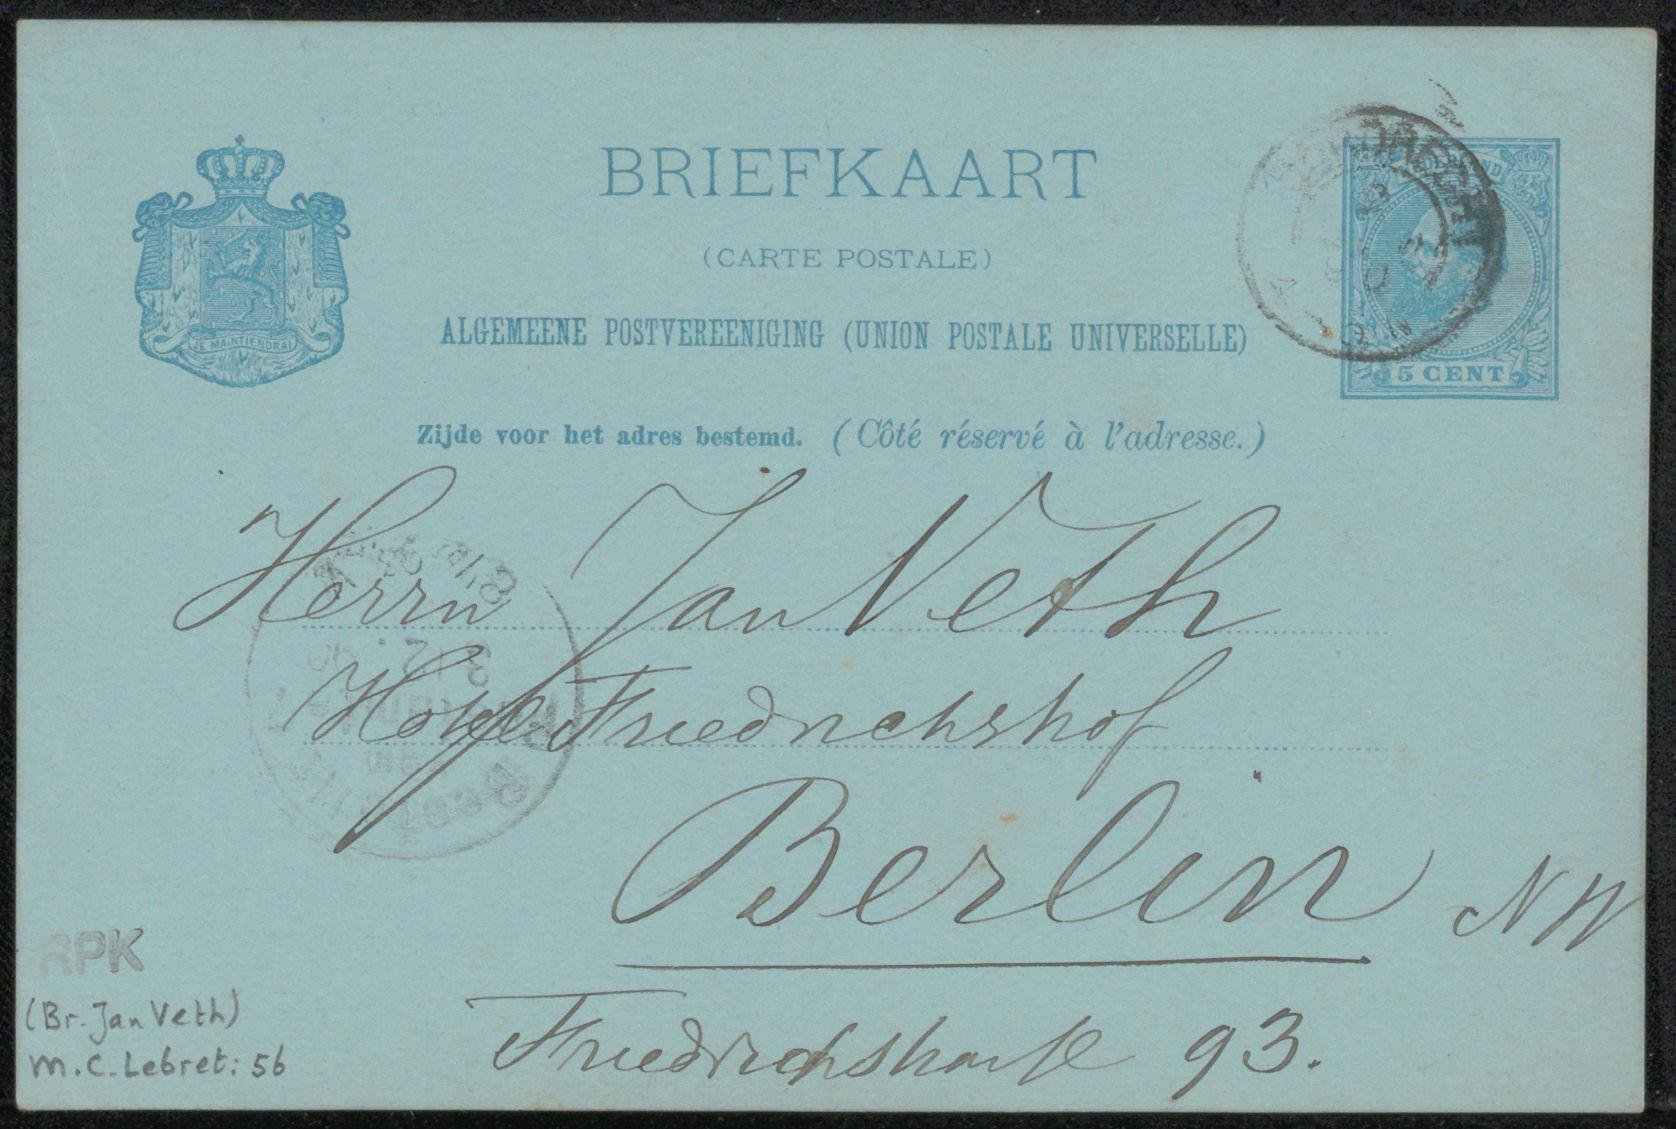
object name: postcard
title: Briefkaart aan Jan Veth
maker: martinus cornelis lebret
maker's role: verzamelaar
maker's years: 1833-1894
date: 1890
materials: cardboard, ink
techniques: pen, writing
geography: dordrecht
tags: painter, print maker, draughtsman, designer, jan veth, printed matter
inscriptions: collector's mark: ‘RPK’